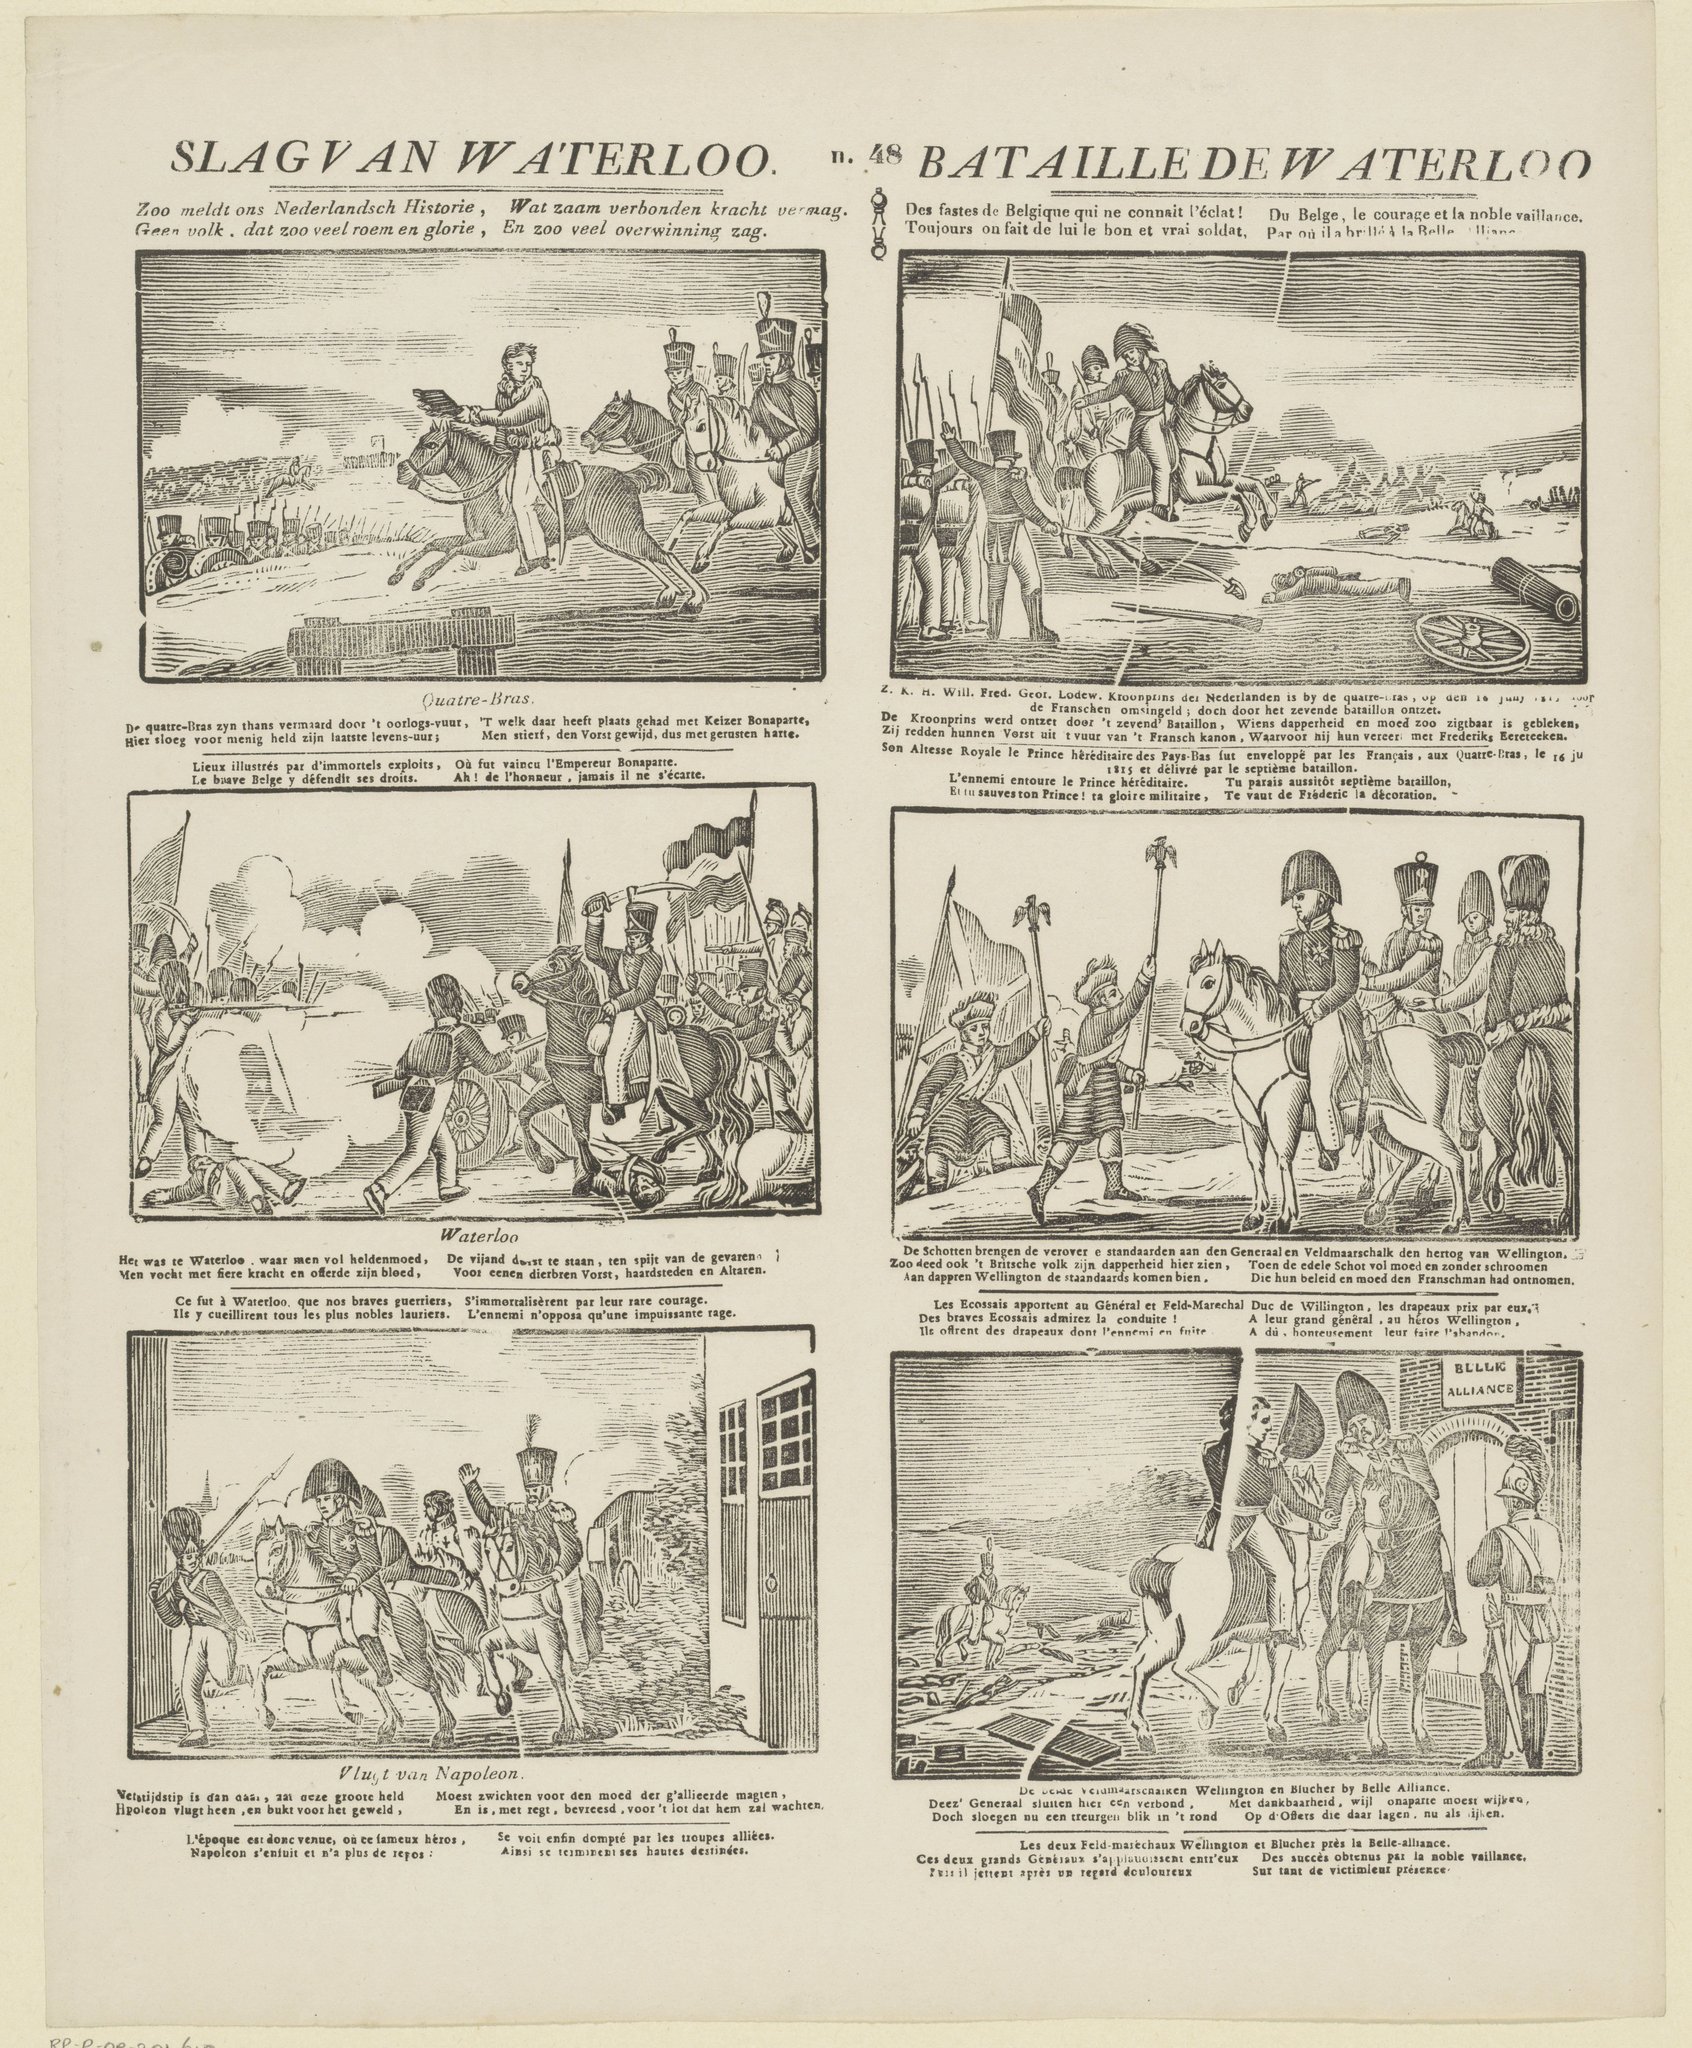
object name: popular print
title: Slag van Waterloo / Bataille de Waterloo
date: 1800-1833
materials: paper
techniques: letterpress printing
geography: turnhout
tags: battle, the soldier; the soldier's life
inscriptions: collector's mark: Lugt 2760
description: Blad met 6 voorstellingen over de Slag bij Waterloo. Onder elke voorstelling een vierregelig vers in het Nederlands en in het Frans. Genummerd midden boven: 48.